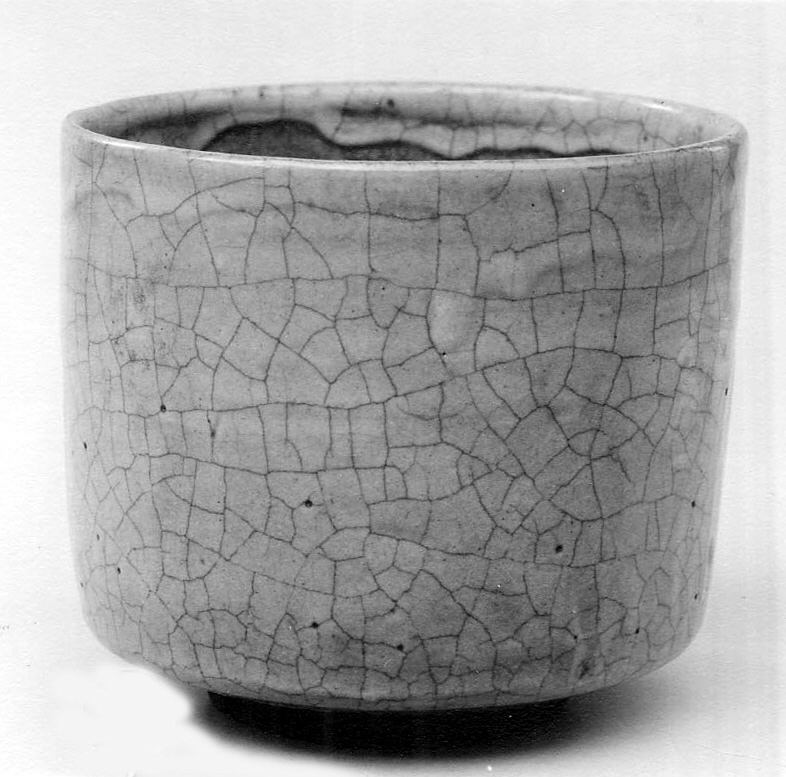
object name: teabowl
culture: japanese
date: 1850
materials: clay, glaze